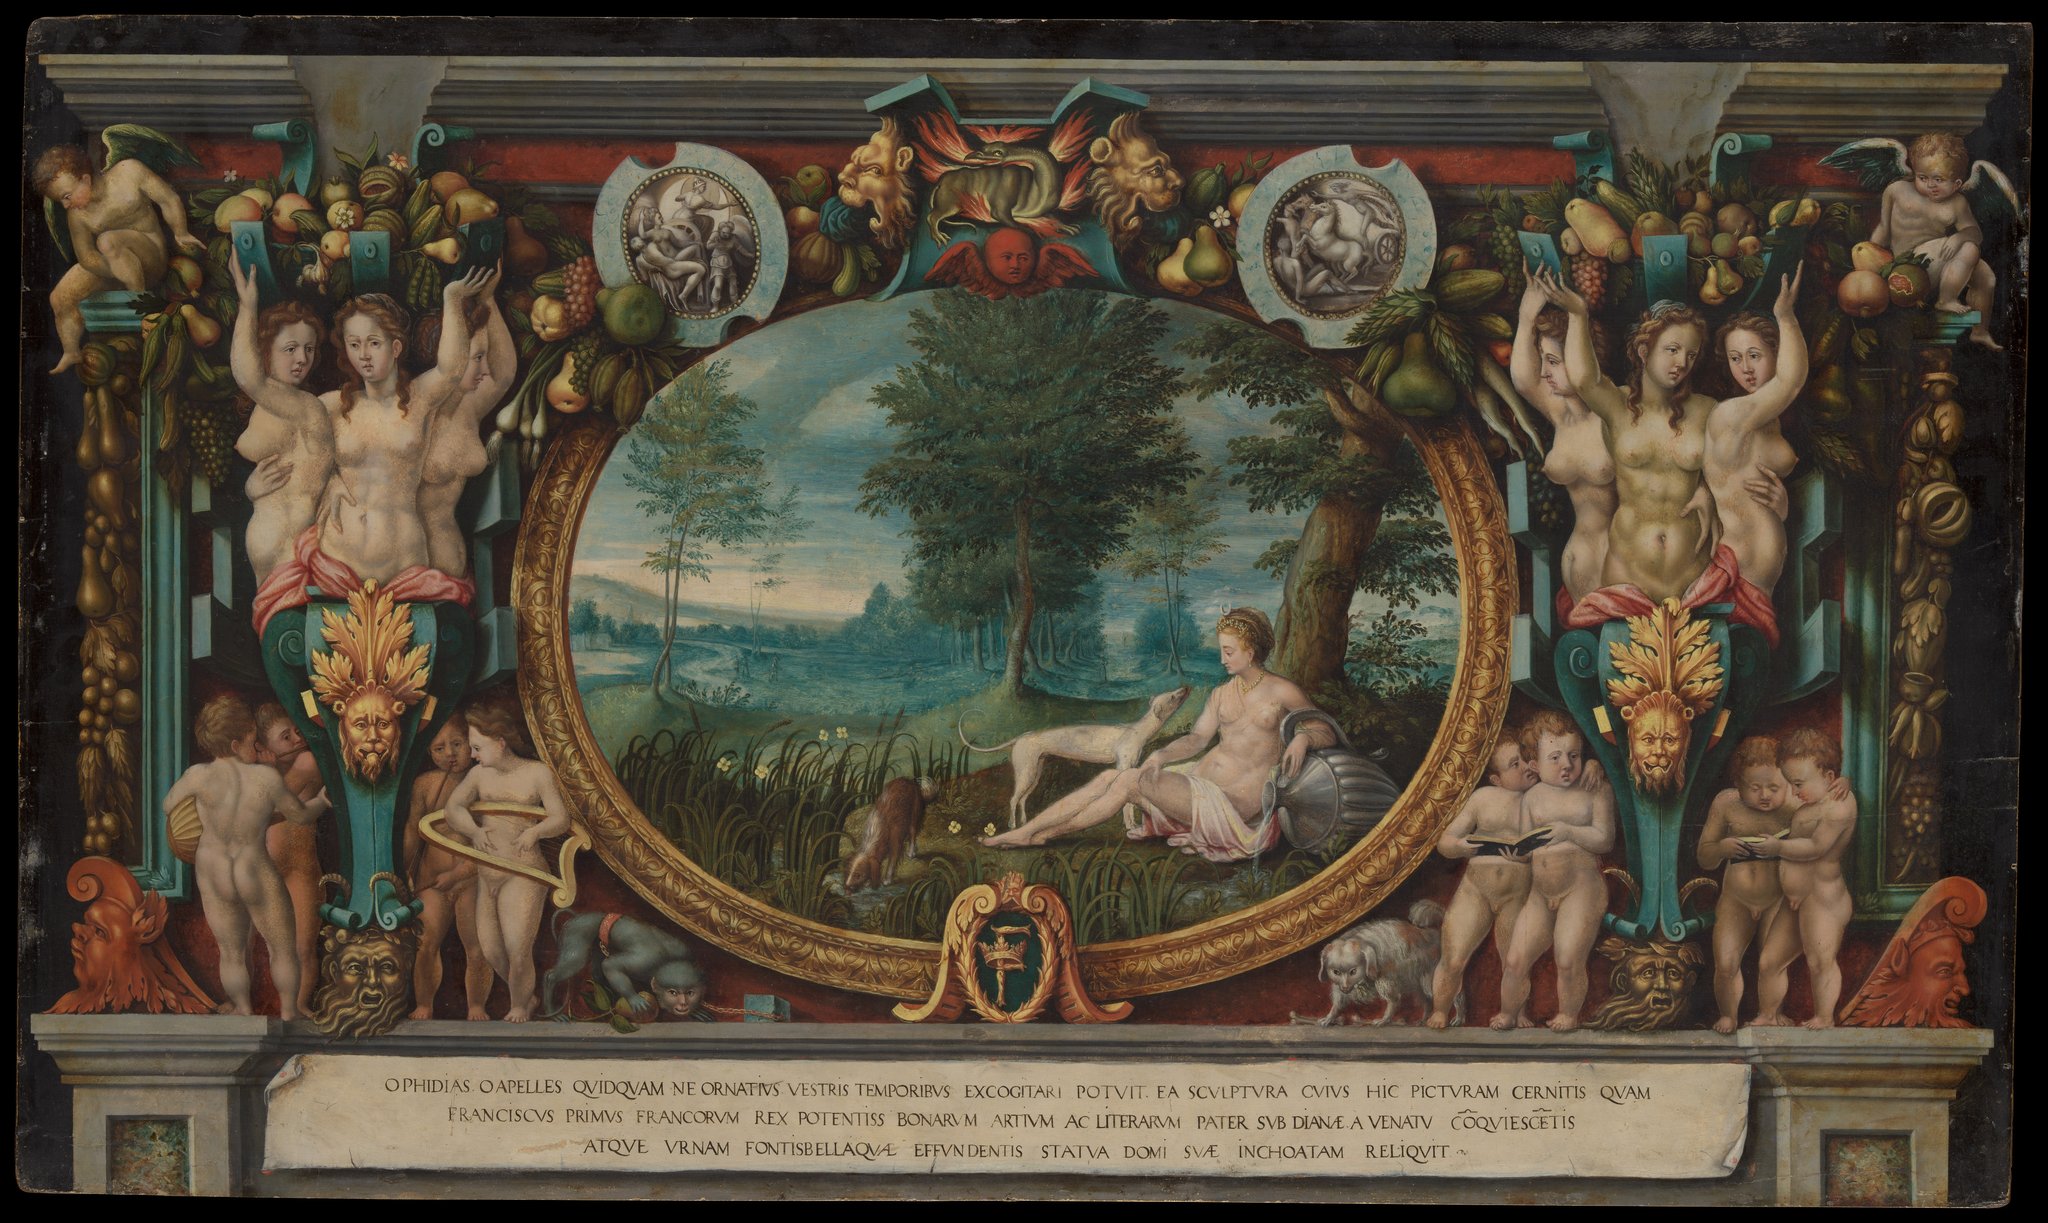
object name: painting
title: The Nymph of Fontainebleau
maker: french (fontainebleau) painter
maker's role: artist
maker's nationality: french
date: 1550-1574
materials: oil, wood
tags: books,fruit,heads,reading,dragons,nymphs,putti,diana,dogs,lions,monkeys,flowers,landscapes,trees,urns,lyres